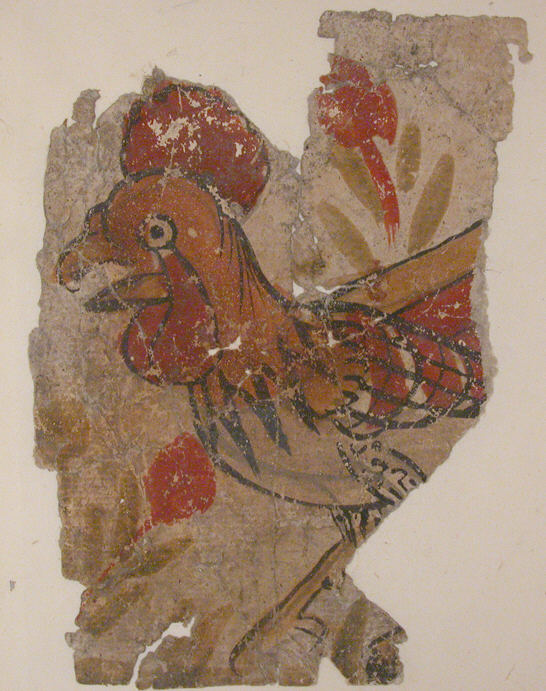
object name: folio from an illustrated manuscript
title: "Rooster", Folio from a Dispersed Manuscript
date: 901-1100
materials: paper, watercolor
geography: egypt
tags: roosters